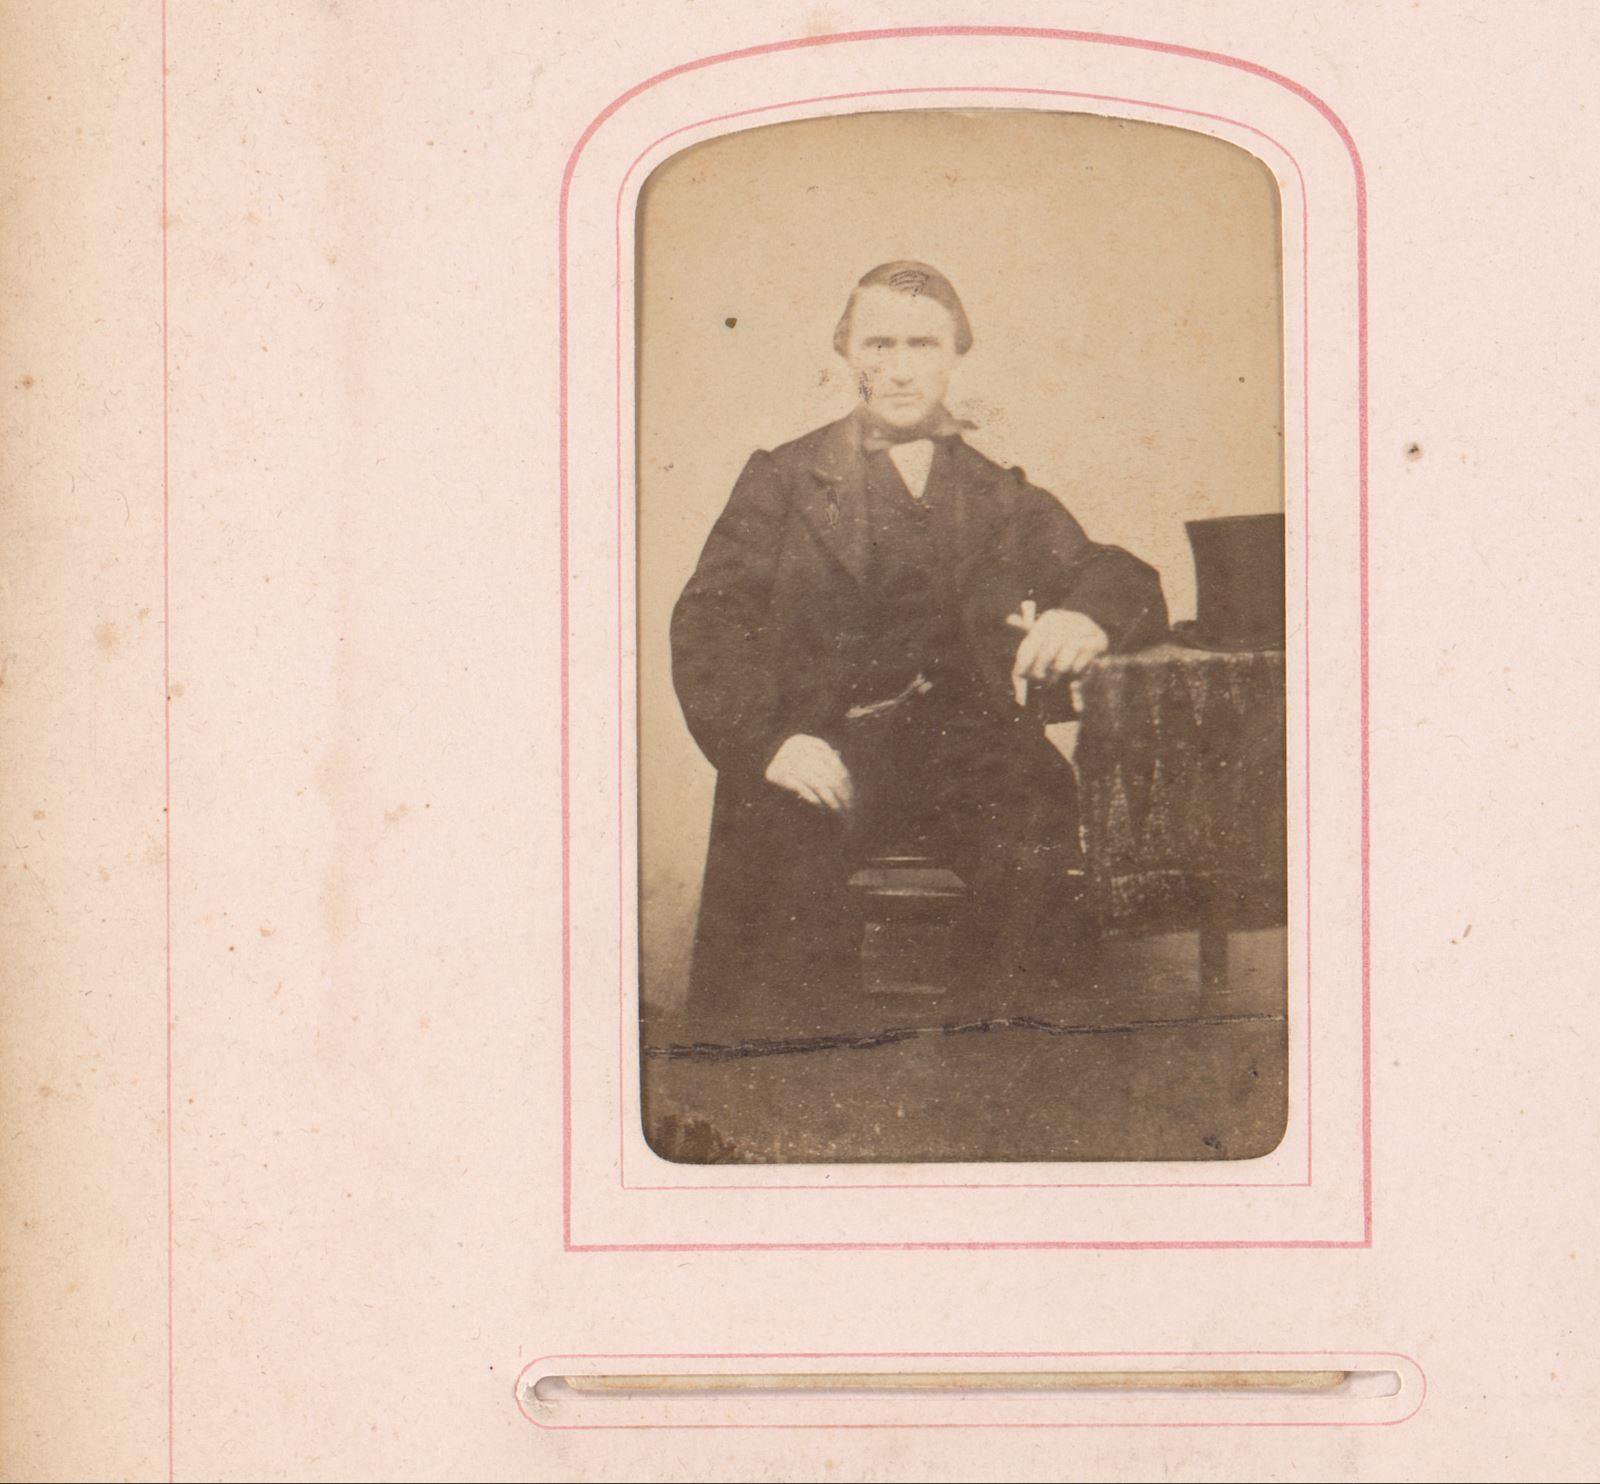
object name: album leaf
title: Nederland, portret zittende man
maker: Anonymous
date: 1855-1885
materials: cardboard, paper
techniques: albumen print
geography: netherlands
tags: adult man, historical persons, head-gear: top hat, netherlands